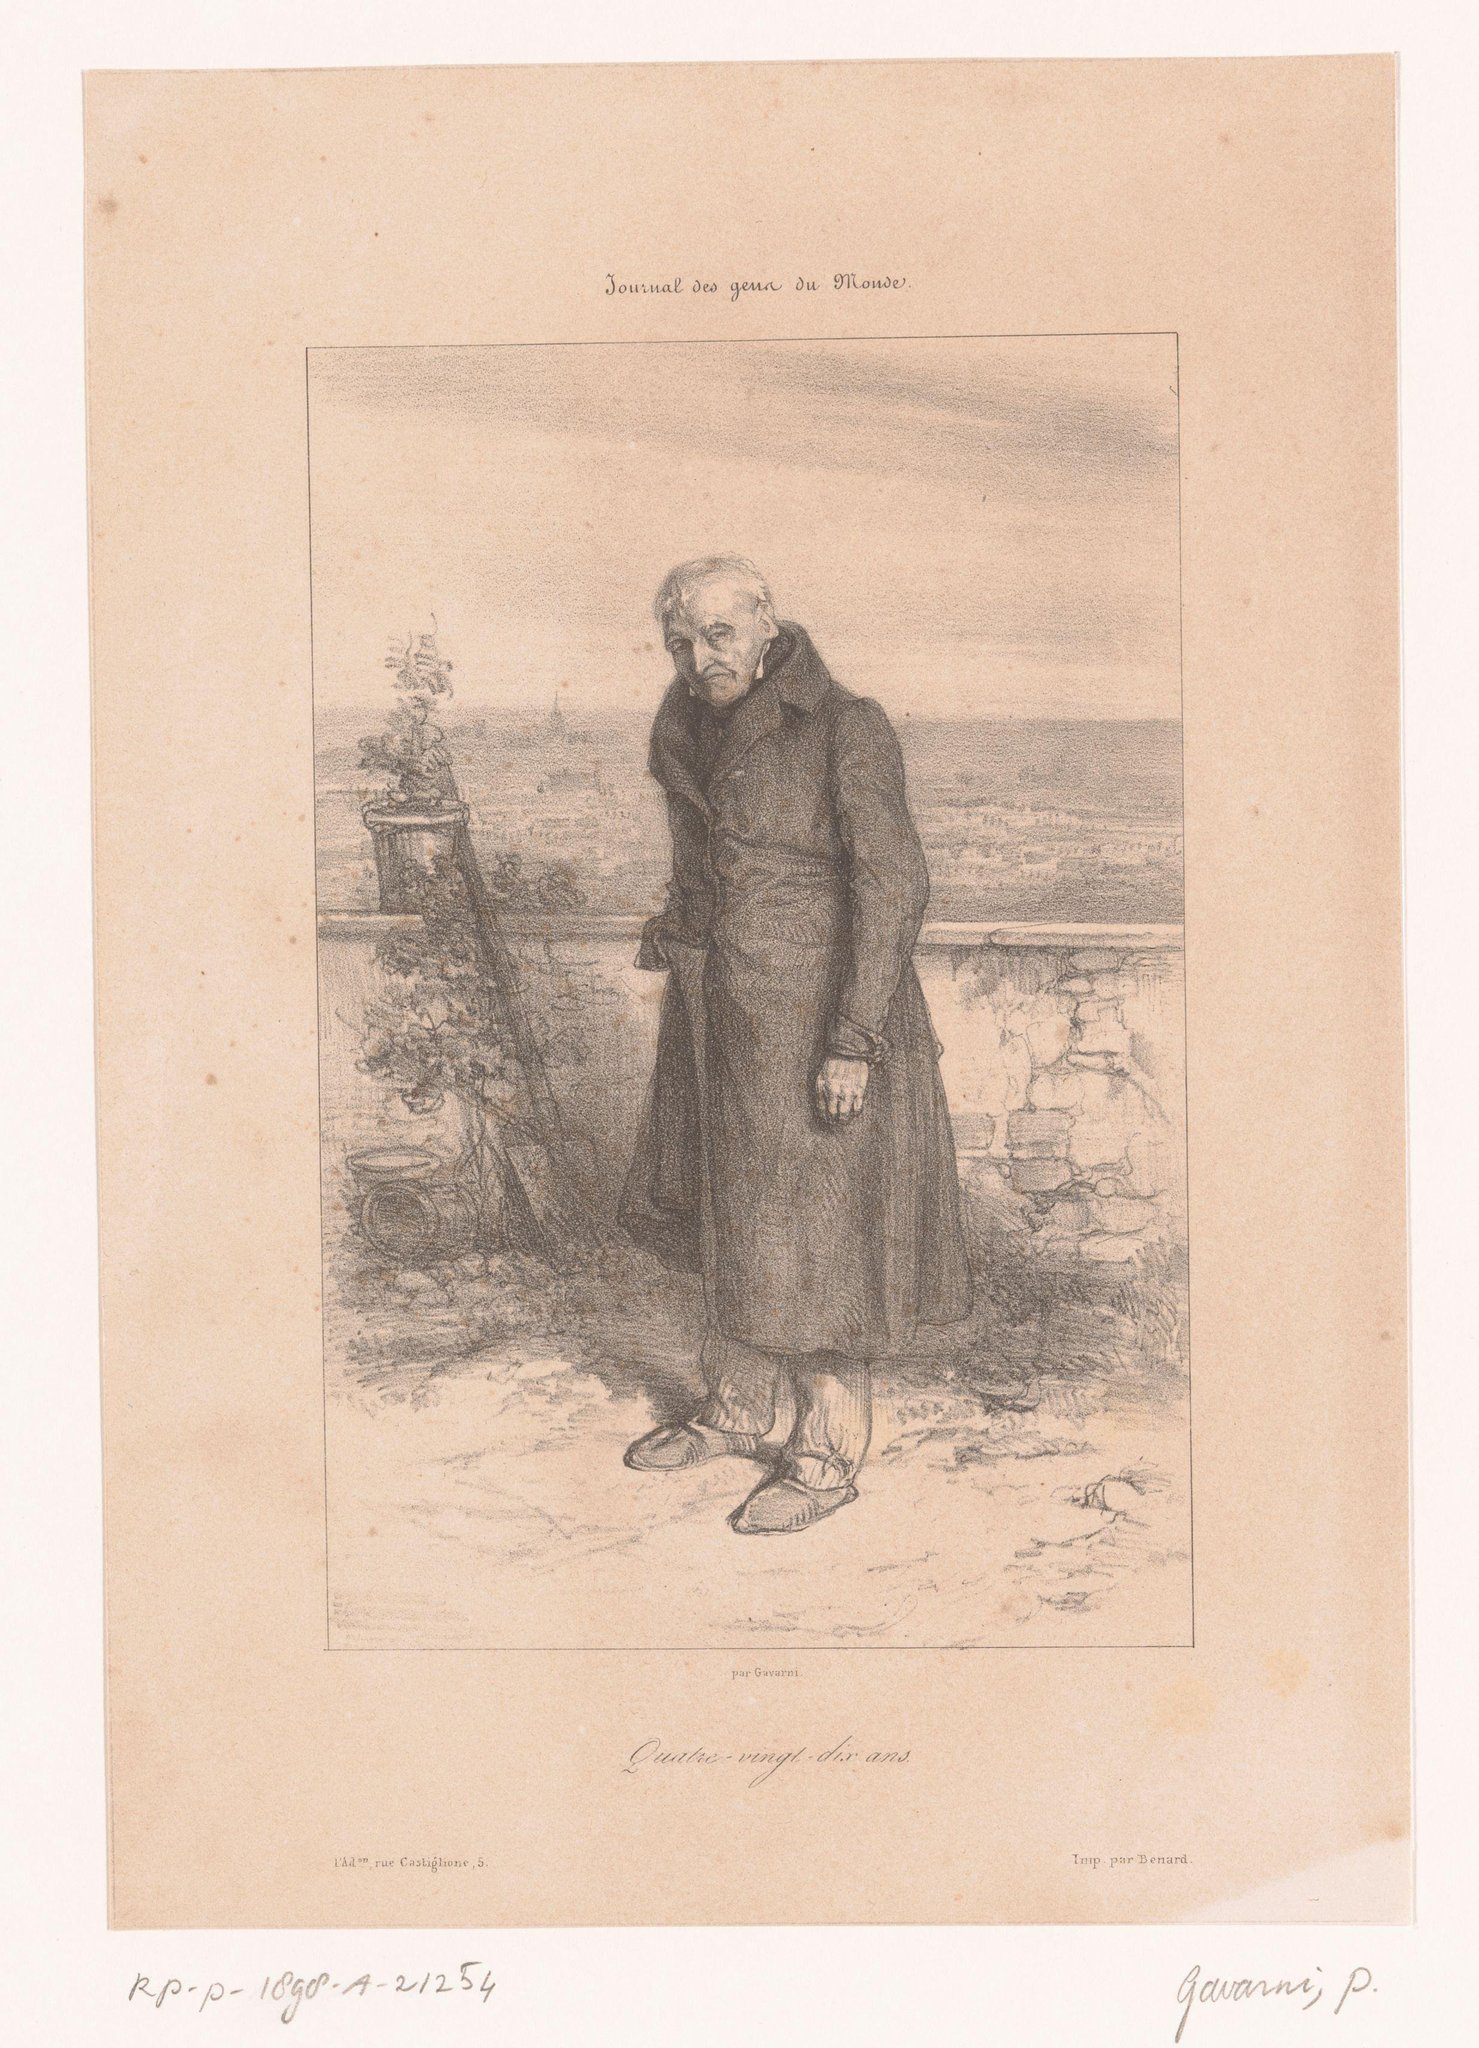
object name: print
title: Quatre-vingt-dix ans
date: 1834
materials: paper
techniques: lithograph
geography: paris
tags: historical persons, old man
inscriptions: collector's mark: Lugt 964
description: Prent gebruikt voor: Journal des gens du Monde.